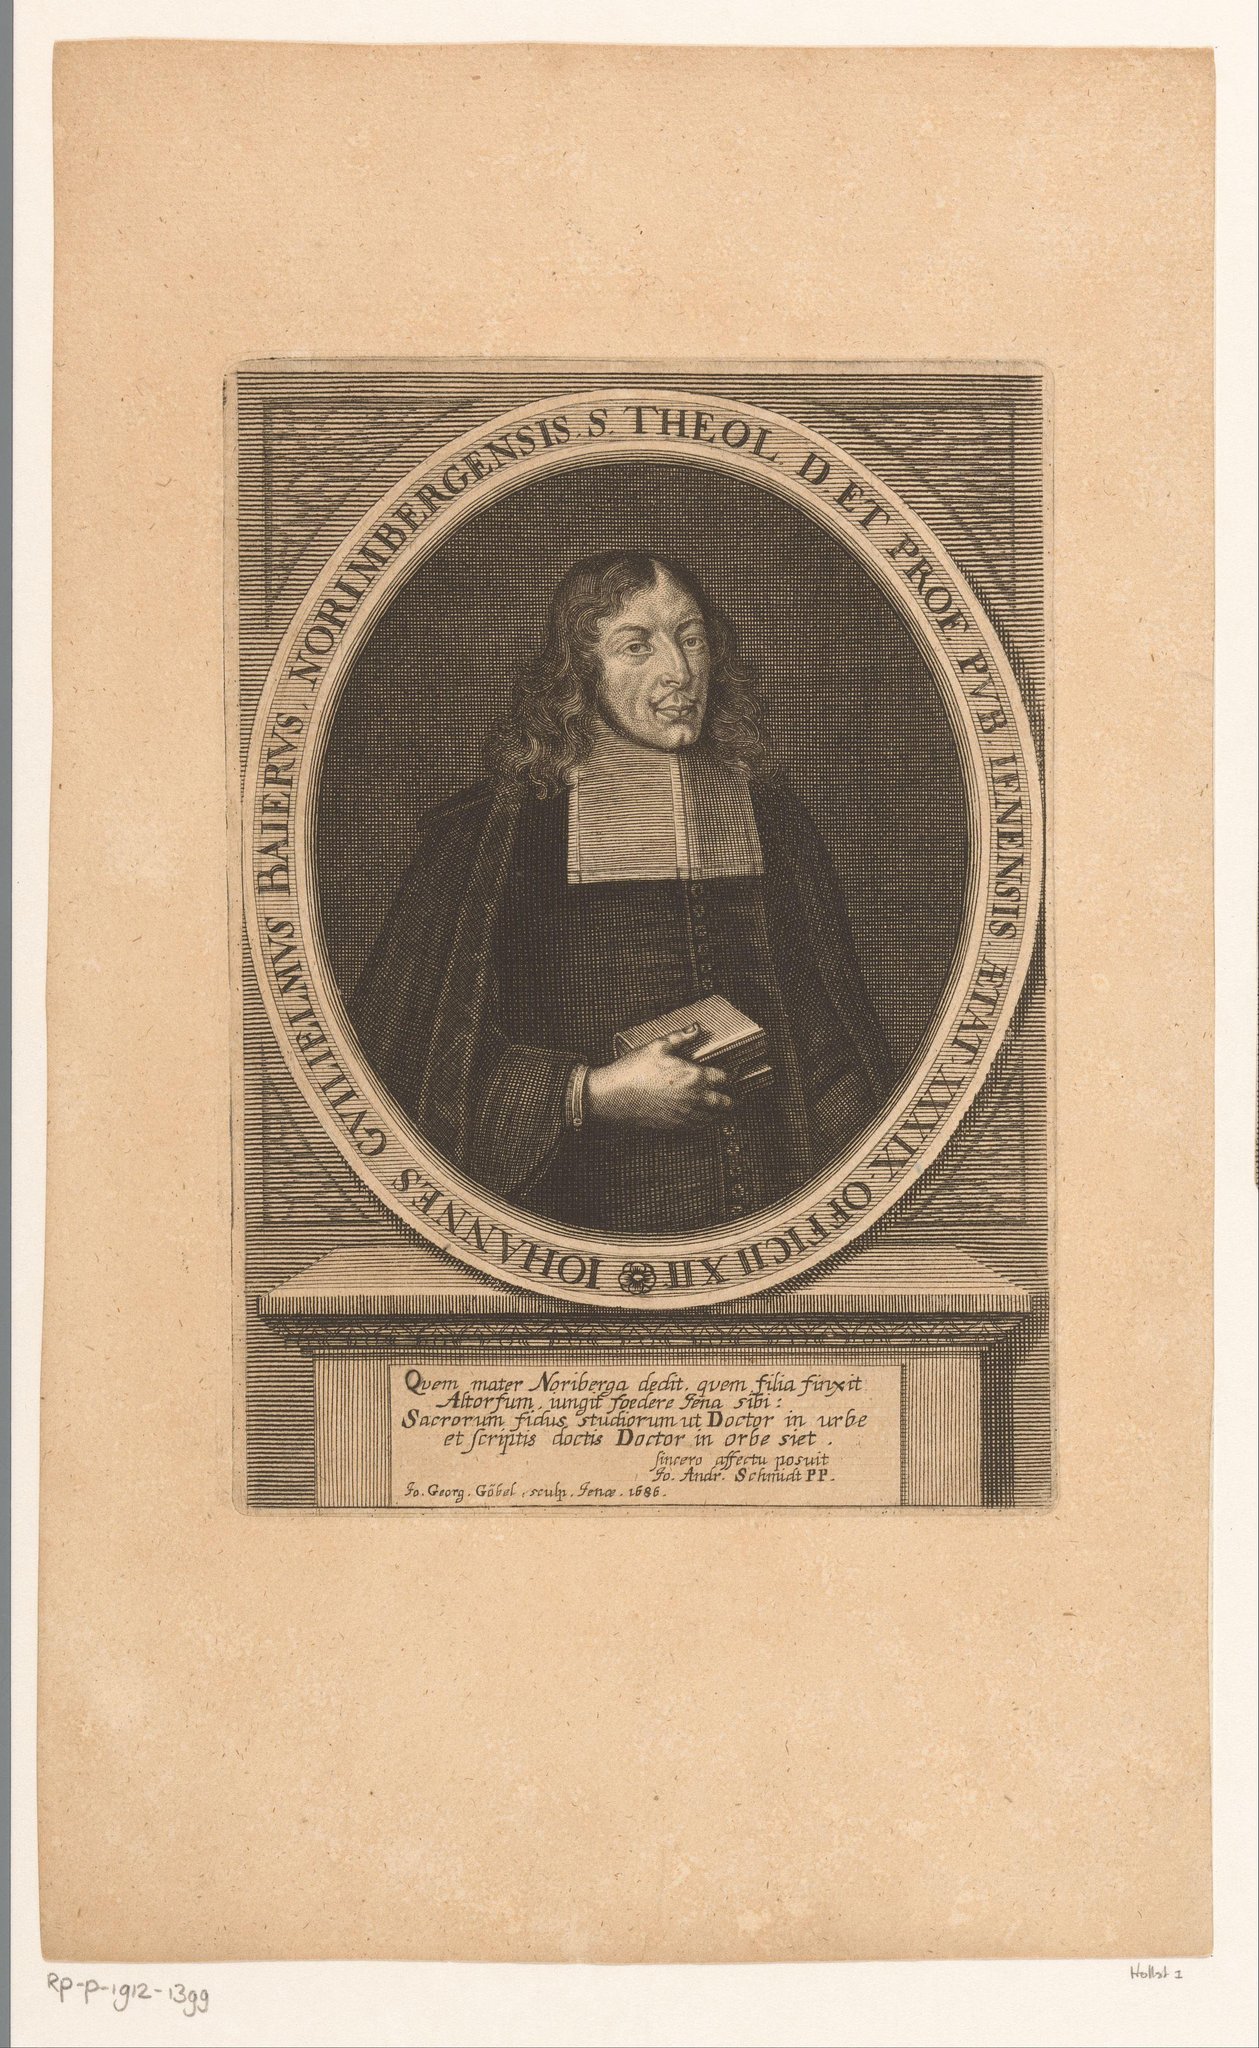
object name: print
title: Portret van Johann Wilhelm Baier op 39-jarige leeftijd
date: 1686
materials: paper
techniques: engraving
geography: jena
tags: theologian, historical persons, book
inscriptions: collector's mark: Lugt 2228